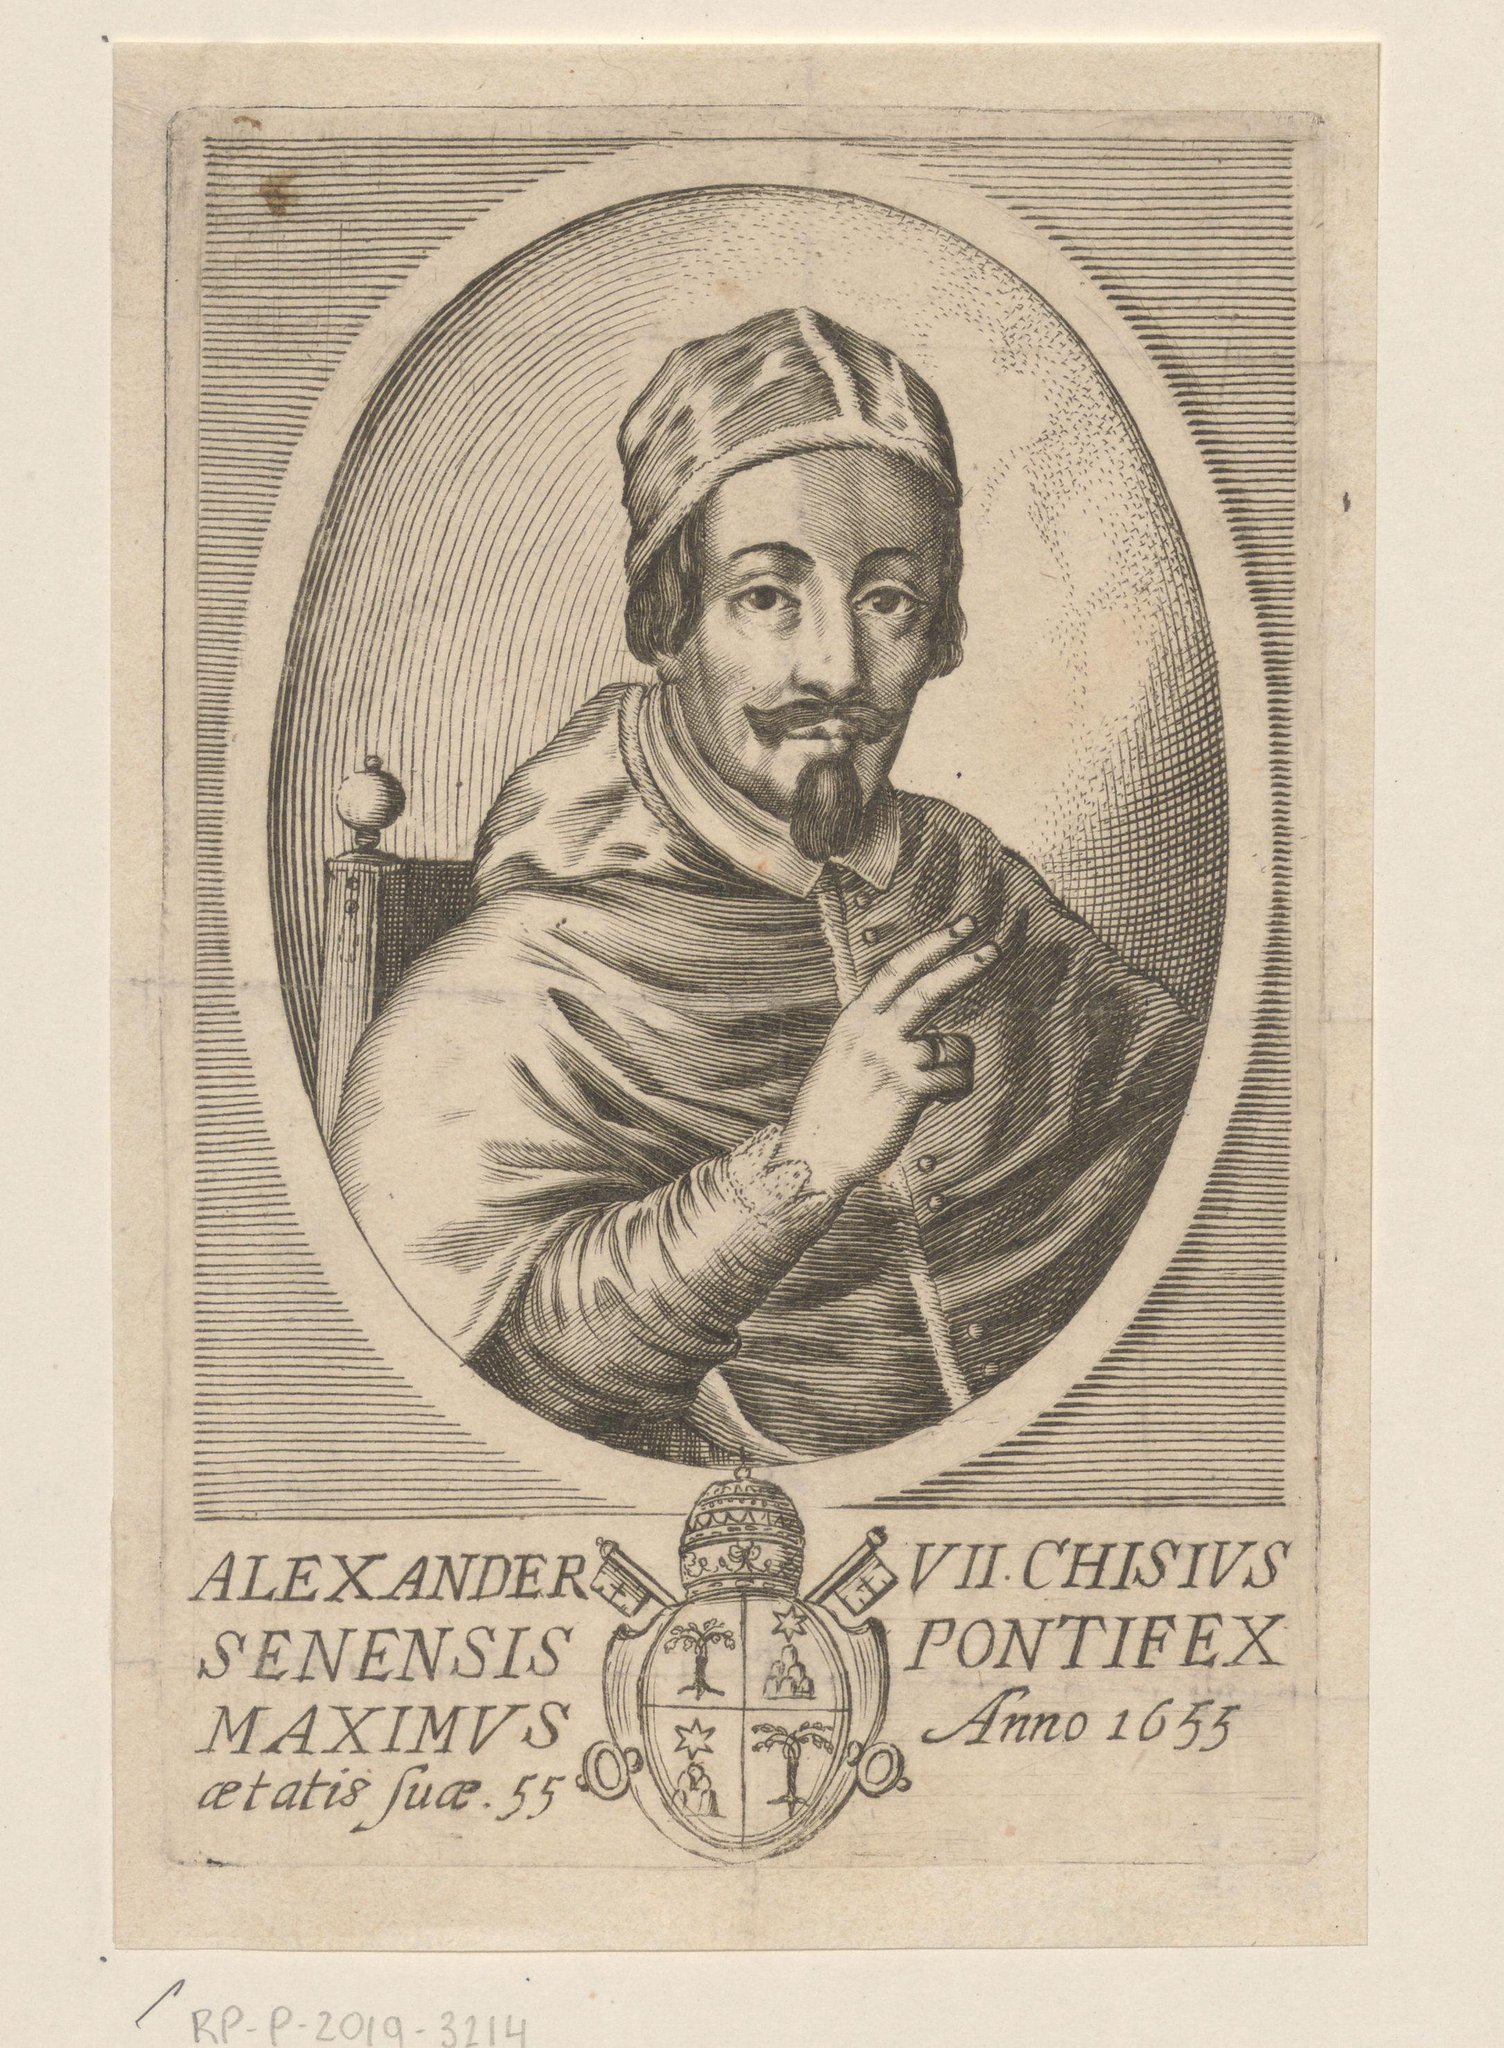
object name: print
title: Portret van paus Alexander VII op 55-jarige leeftijd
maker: Anonymous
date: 1655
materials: paper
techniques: engraving, etching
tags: rome, alexander vii, historical persons, armorial bearing, heraldry